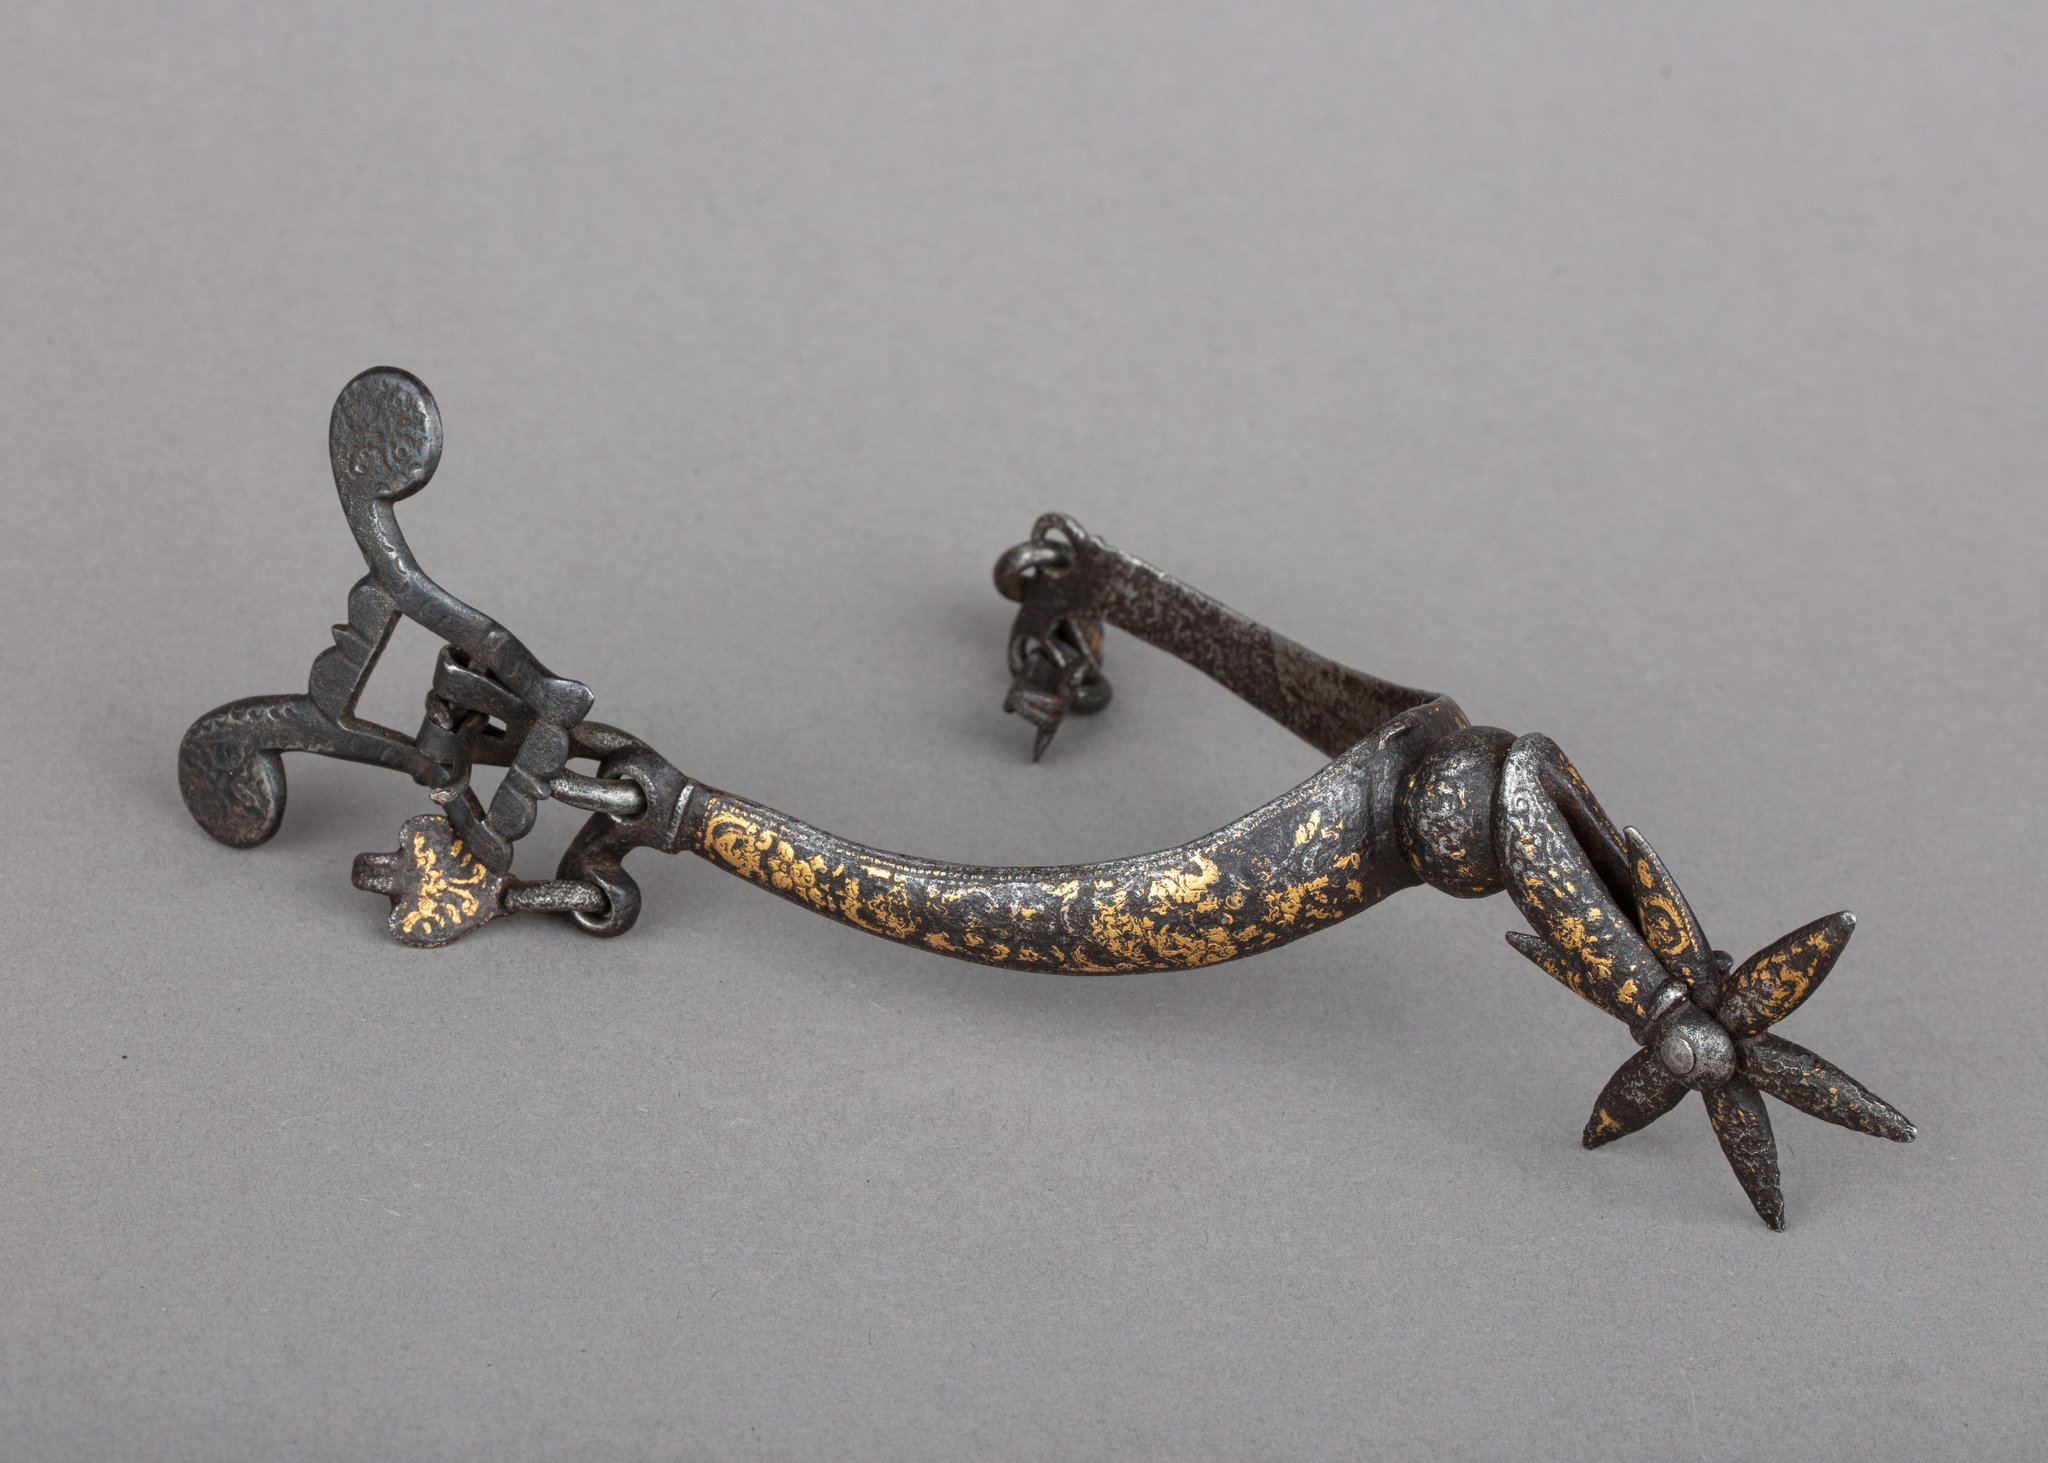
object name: spur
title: Rowel Spur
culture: french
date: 1634-1666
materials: gold, metal alloy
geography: france